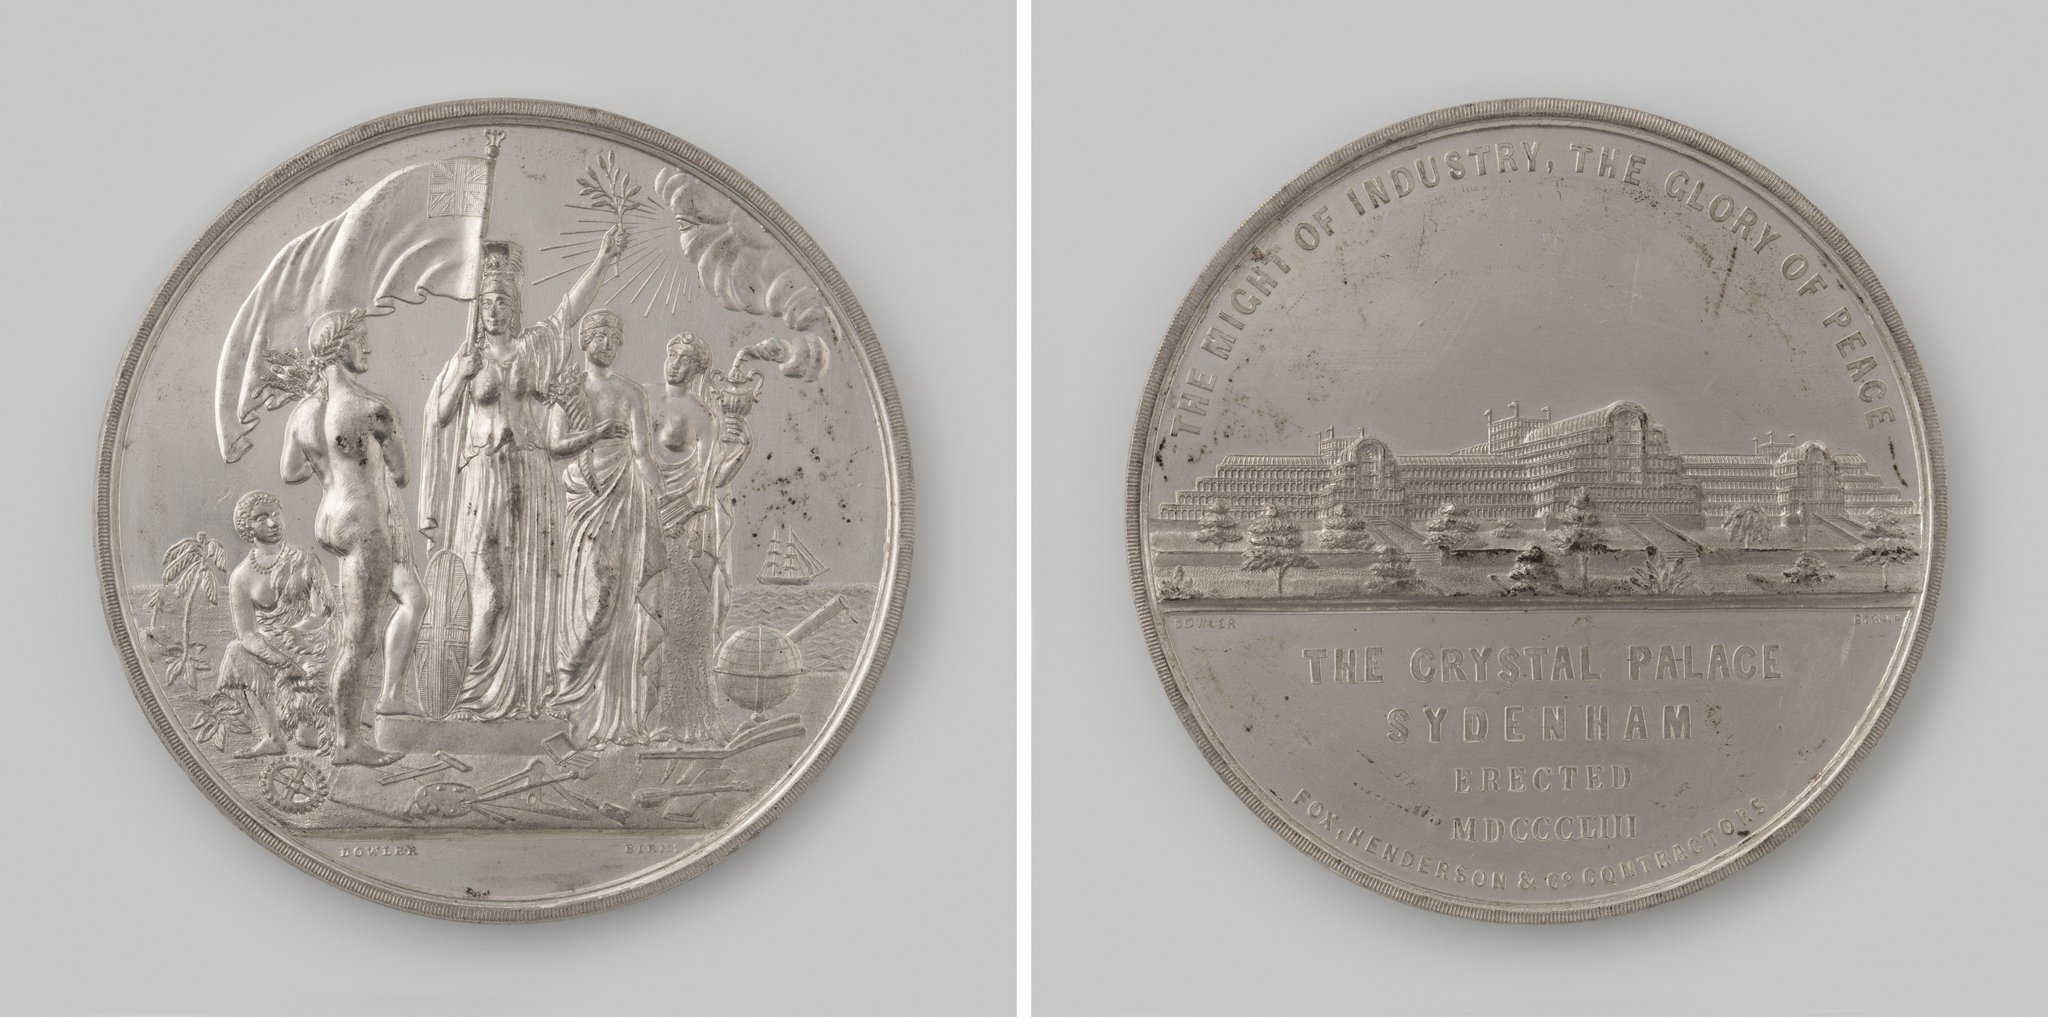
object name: history medal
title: Opening van het tentoonstellingsgebouw van Crystal Palace te Sydenham 1862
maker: george dowler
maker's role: modelleur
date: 1862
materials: tin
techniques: striking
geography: birmingham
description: Tinnen penning, op de voorzijde Brittannia met vlag en olijftak te midden van overzeese onderdanen en symbolen van scheepsbouw en navigatie, op de achtergrond de zee, op de keerzijde een regel tekst, het Crystal Palace en vijf regels tekst.